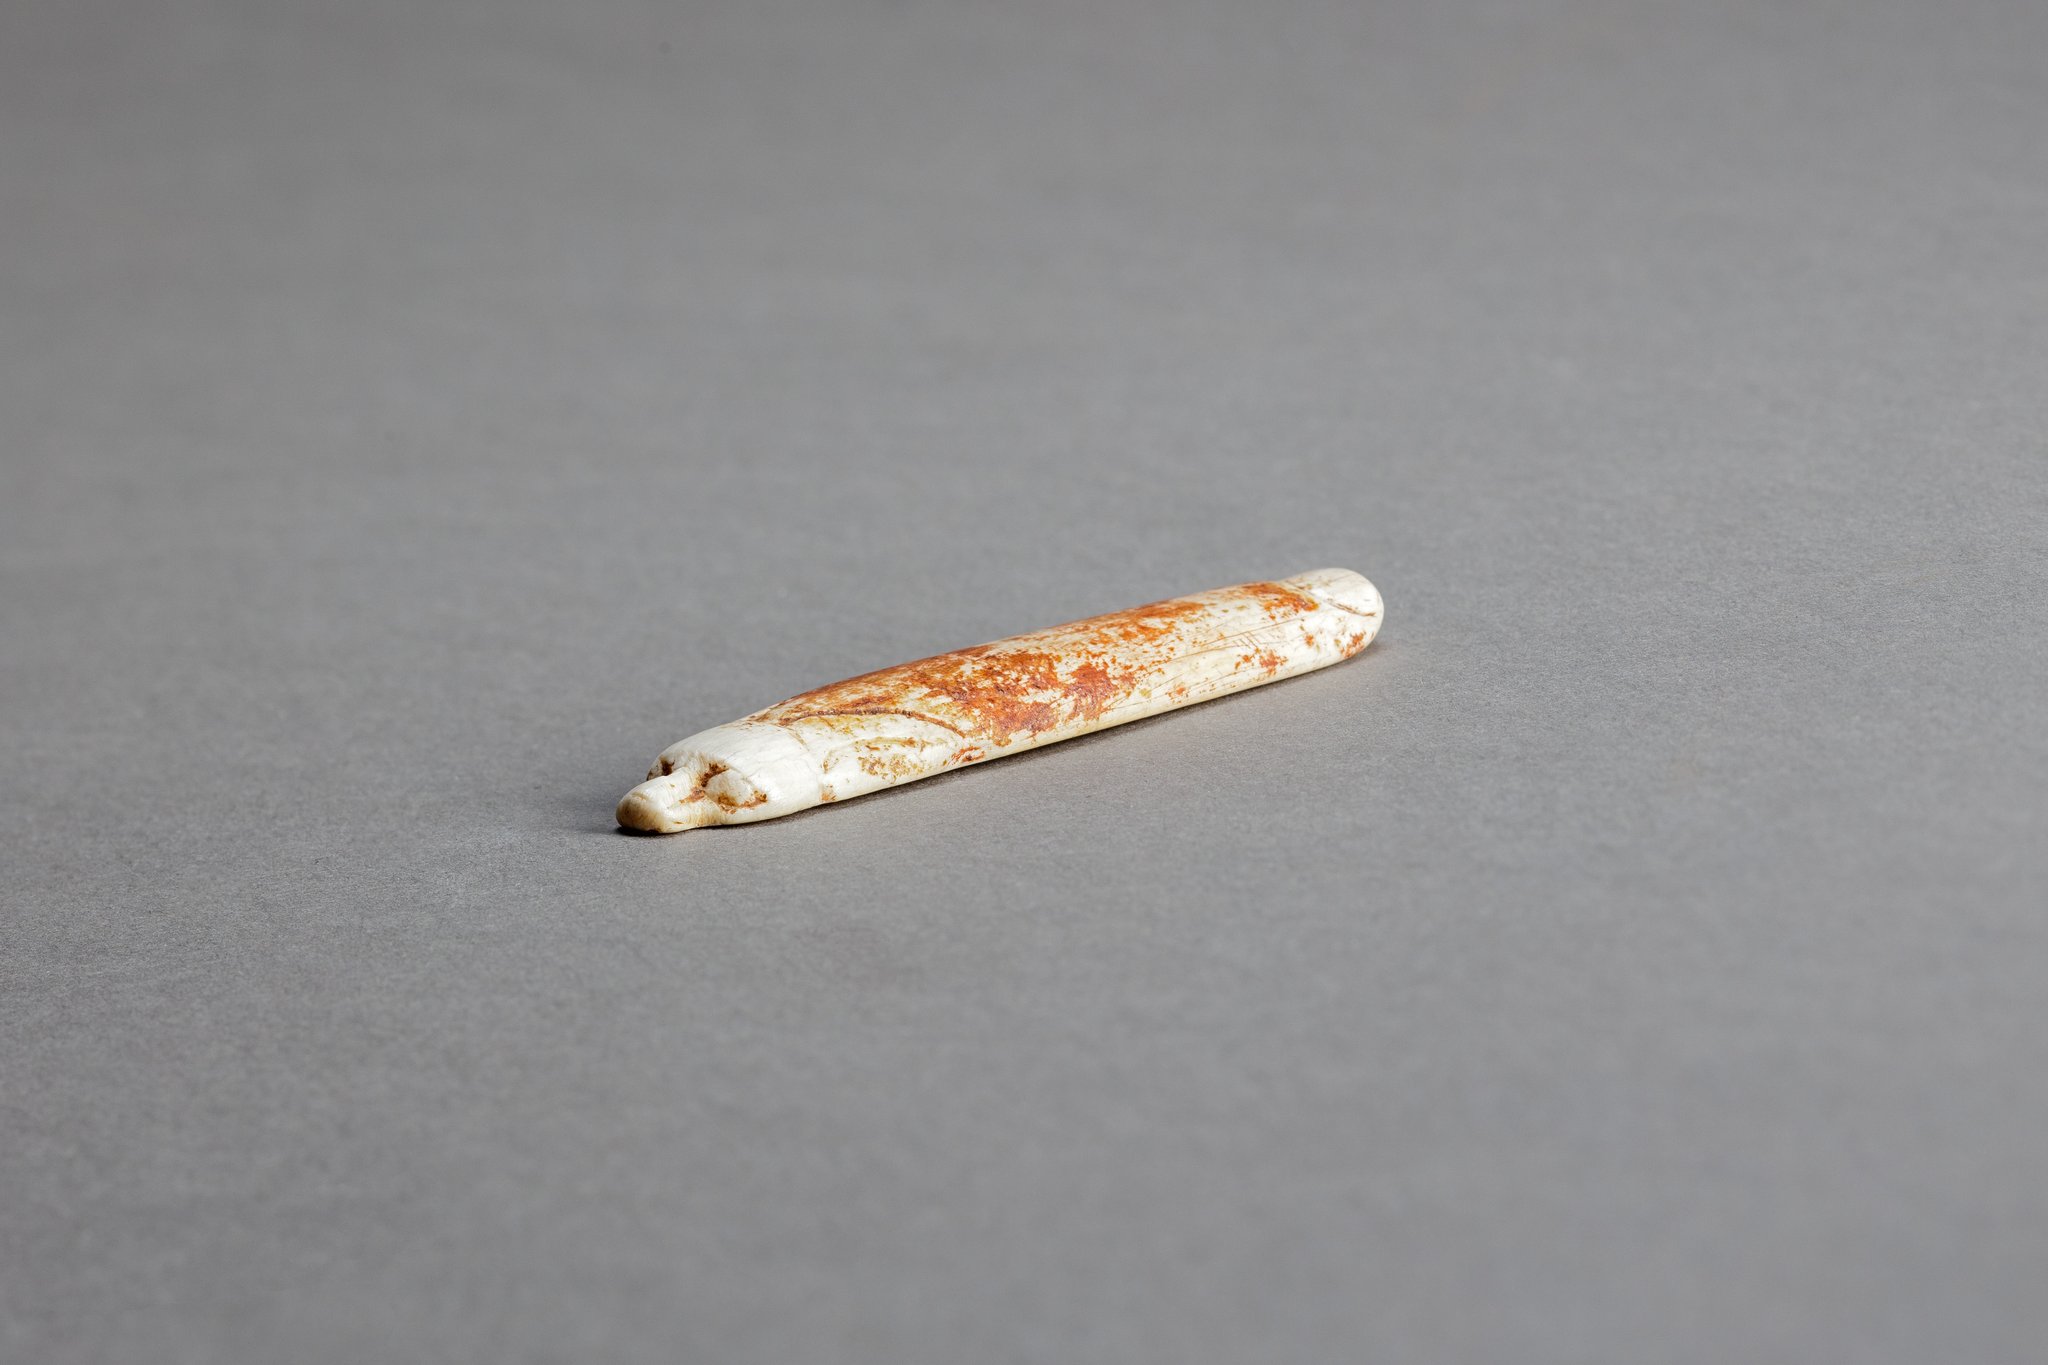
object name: throw stick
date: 1400-1295 BCE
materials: ivory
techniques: tinting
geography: upper egypt, thebes